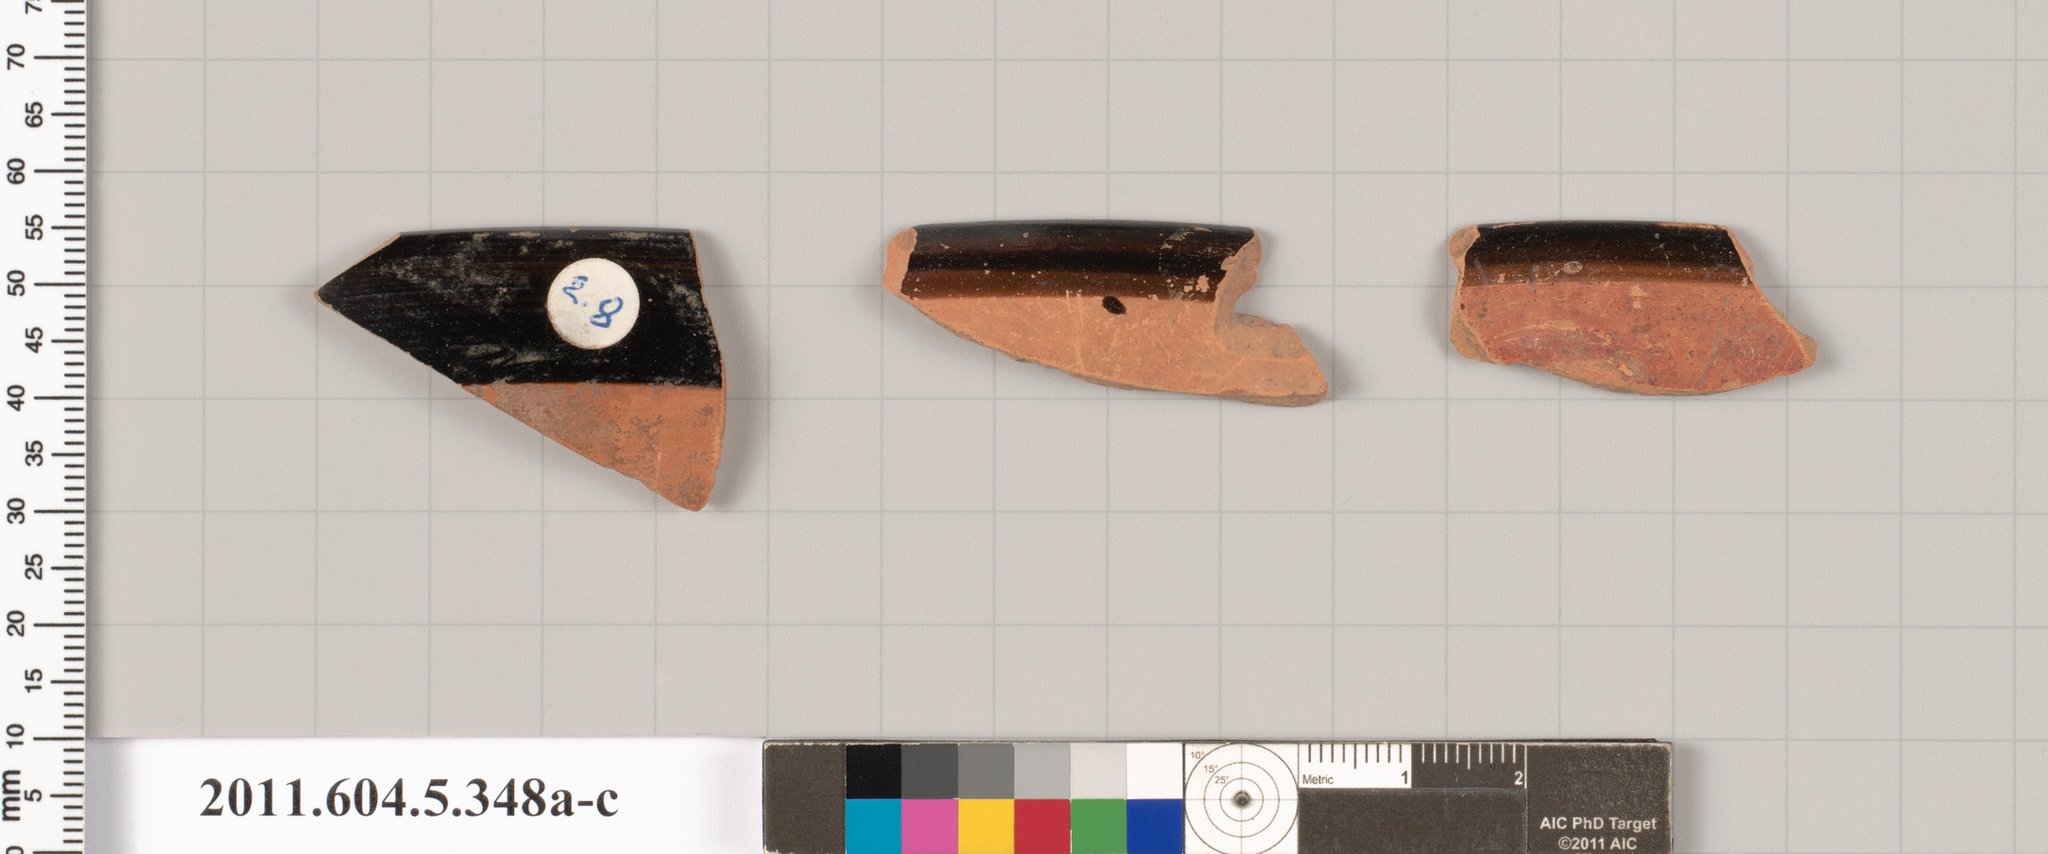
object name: kylix fragment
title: Terracotta rim fragments of kylikes (drinking cups)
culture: greek, attic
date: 600-401 BCE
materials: terracotta